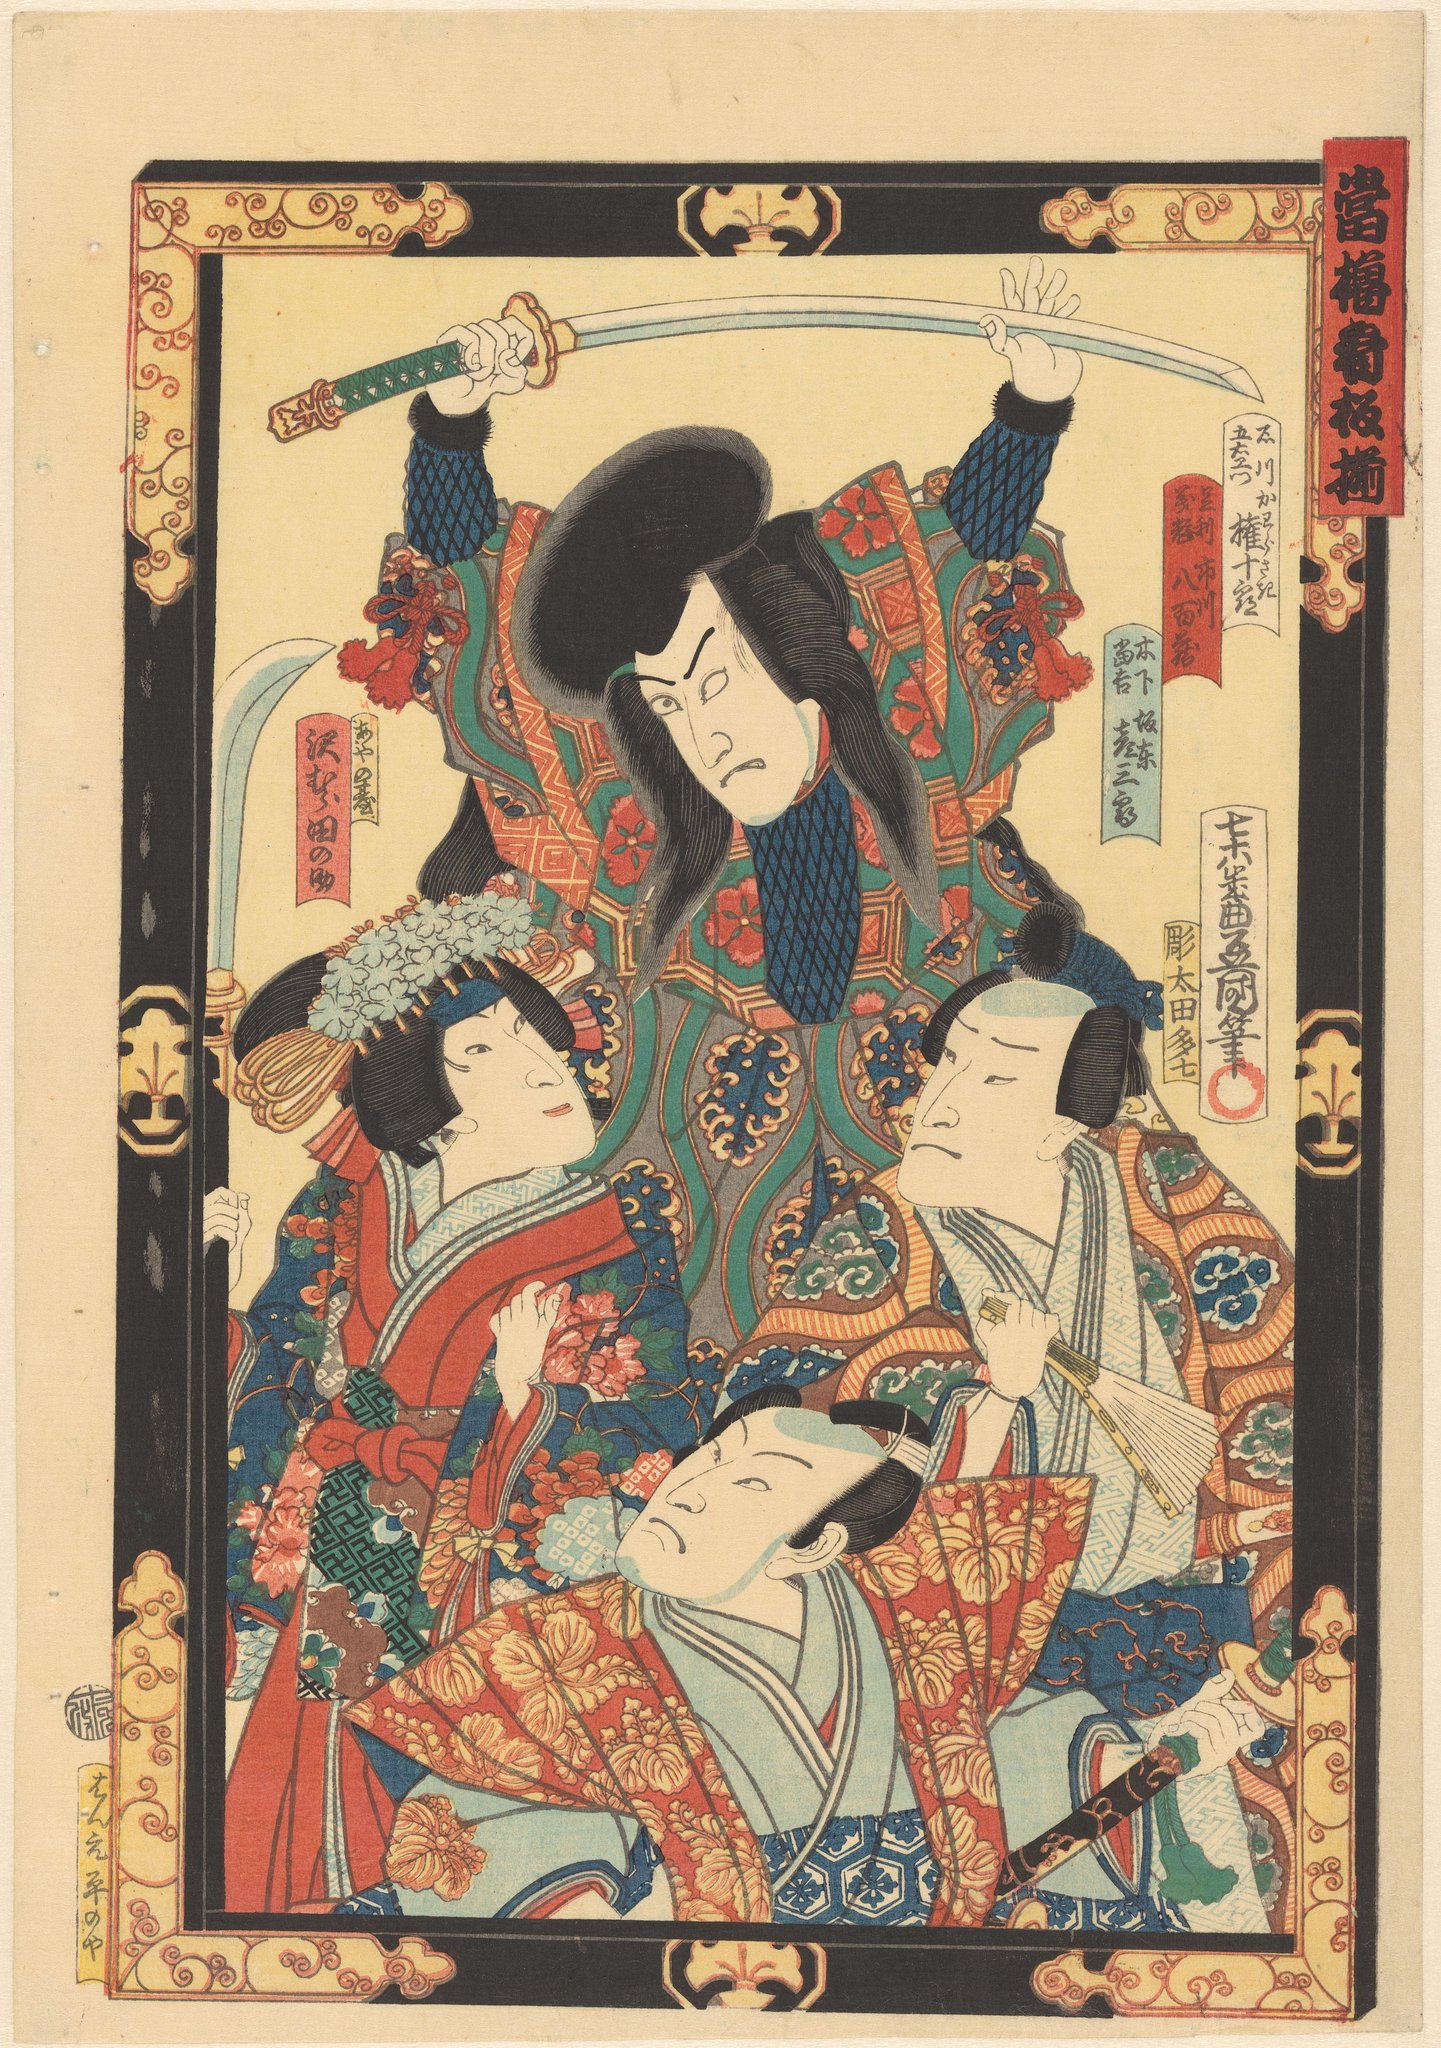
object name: print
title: A Line-up of top stars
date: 1810-1863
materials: paper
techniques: woodcut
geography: japan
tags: group of actors, troupe; actors on the stage, hacking and thrusting weapons: sword, princess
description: De vier hoofdrolspelers uit een kabuki toneelstuk in hun rol afgebeeld binnen een omlijsting van zwart lakwerk met koperen beslag. Bovenaan met zwaard acteur Kawarazaki Gonjûrô I als de beruchte dief Ishikawa Goemon, rechts met waaier acteur Ichikawa Yaozô VI als shogun Yoshiteru, links acteur Sawamura Tanosuke III in de rol van prinses Ayanodai en onderaan acteur Bandô Hikosaburô V als Kinoshita Tôkichi.